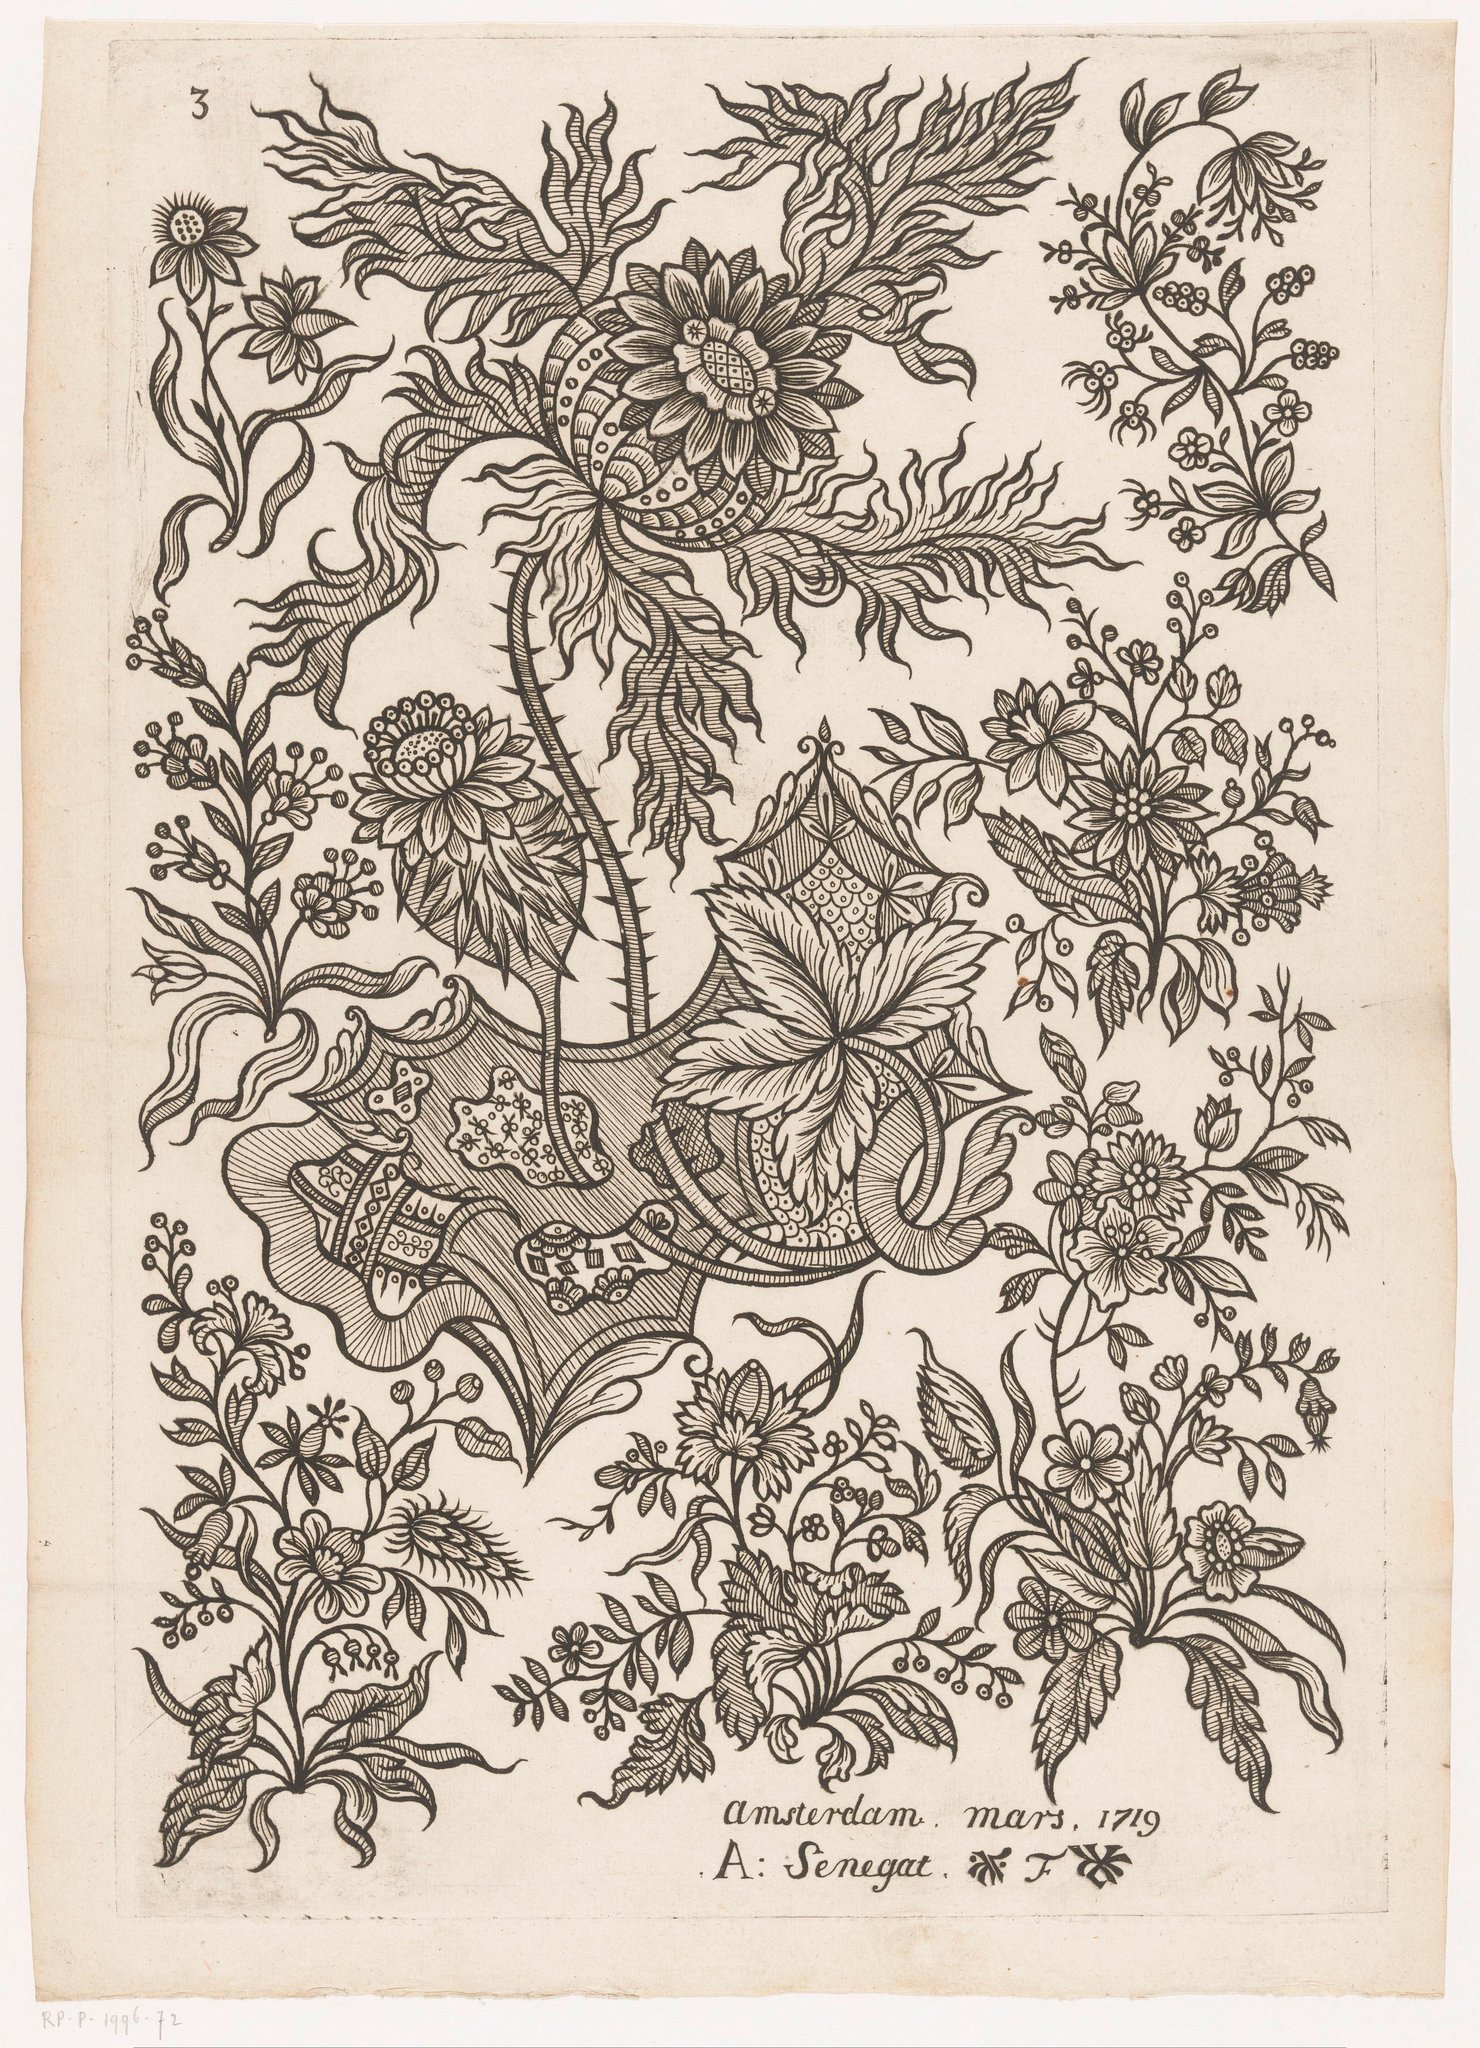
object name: ornament print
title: Ontwerp voor textiel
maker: alexander senegat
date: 1703-1719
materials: paper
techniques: etching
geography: amsterdam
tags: artist (in general) making preliminary designs, sketching, textile industry and clothing industry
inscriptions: collector's mark: Lugt 2228, collector's mark: Lugt 2760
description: Ontwerp voor textiel met fantasiebloemen en -bladeren.